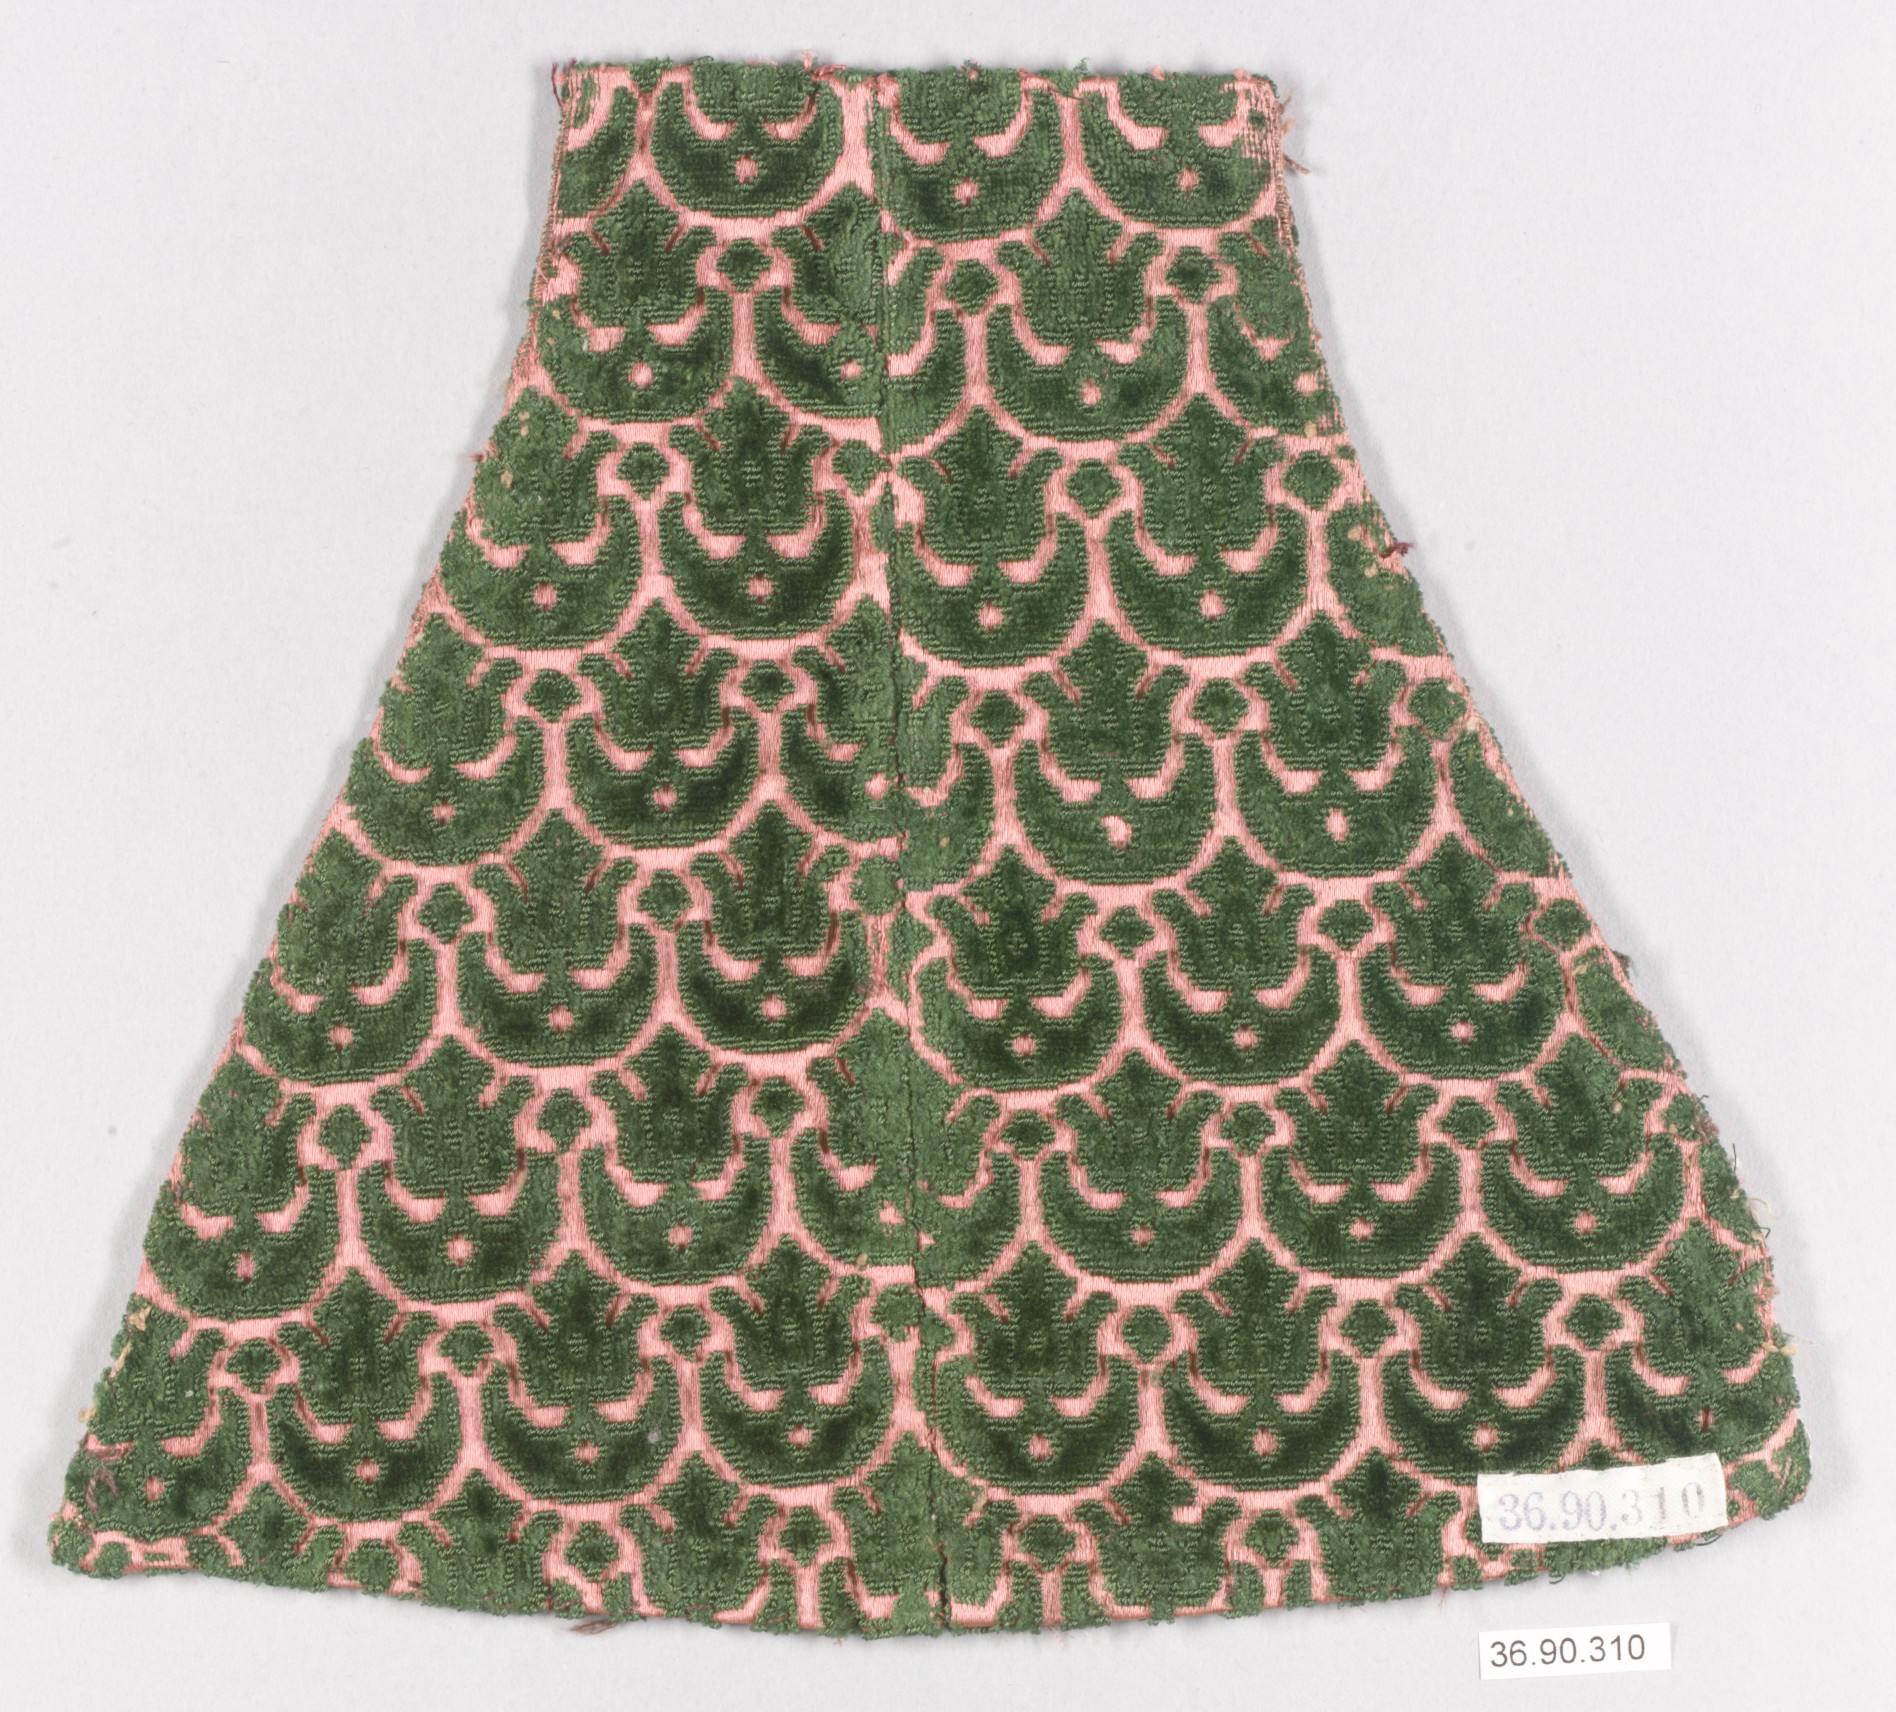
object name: piece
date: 1501-1700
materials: silk